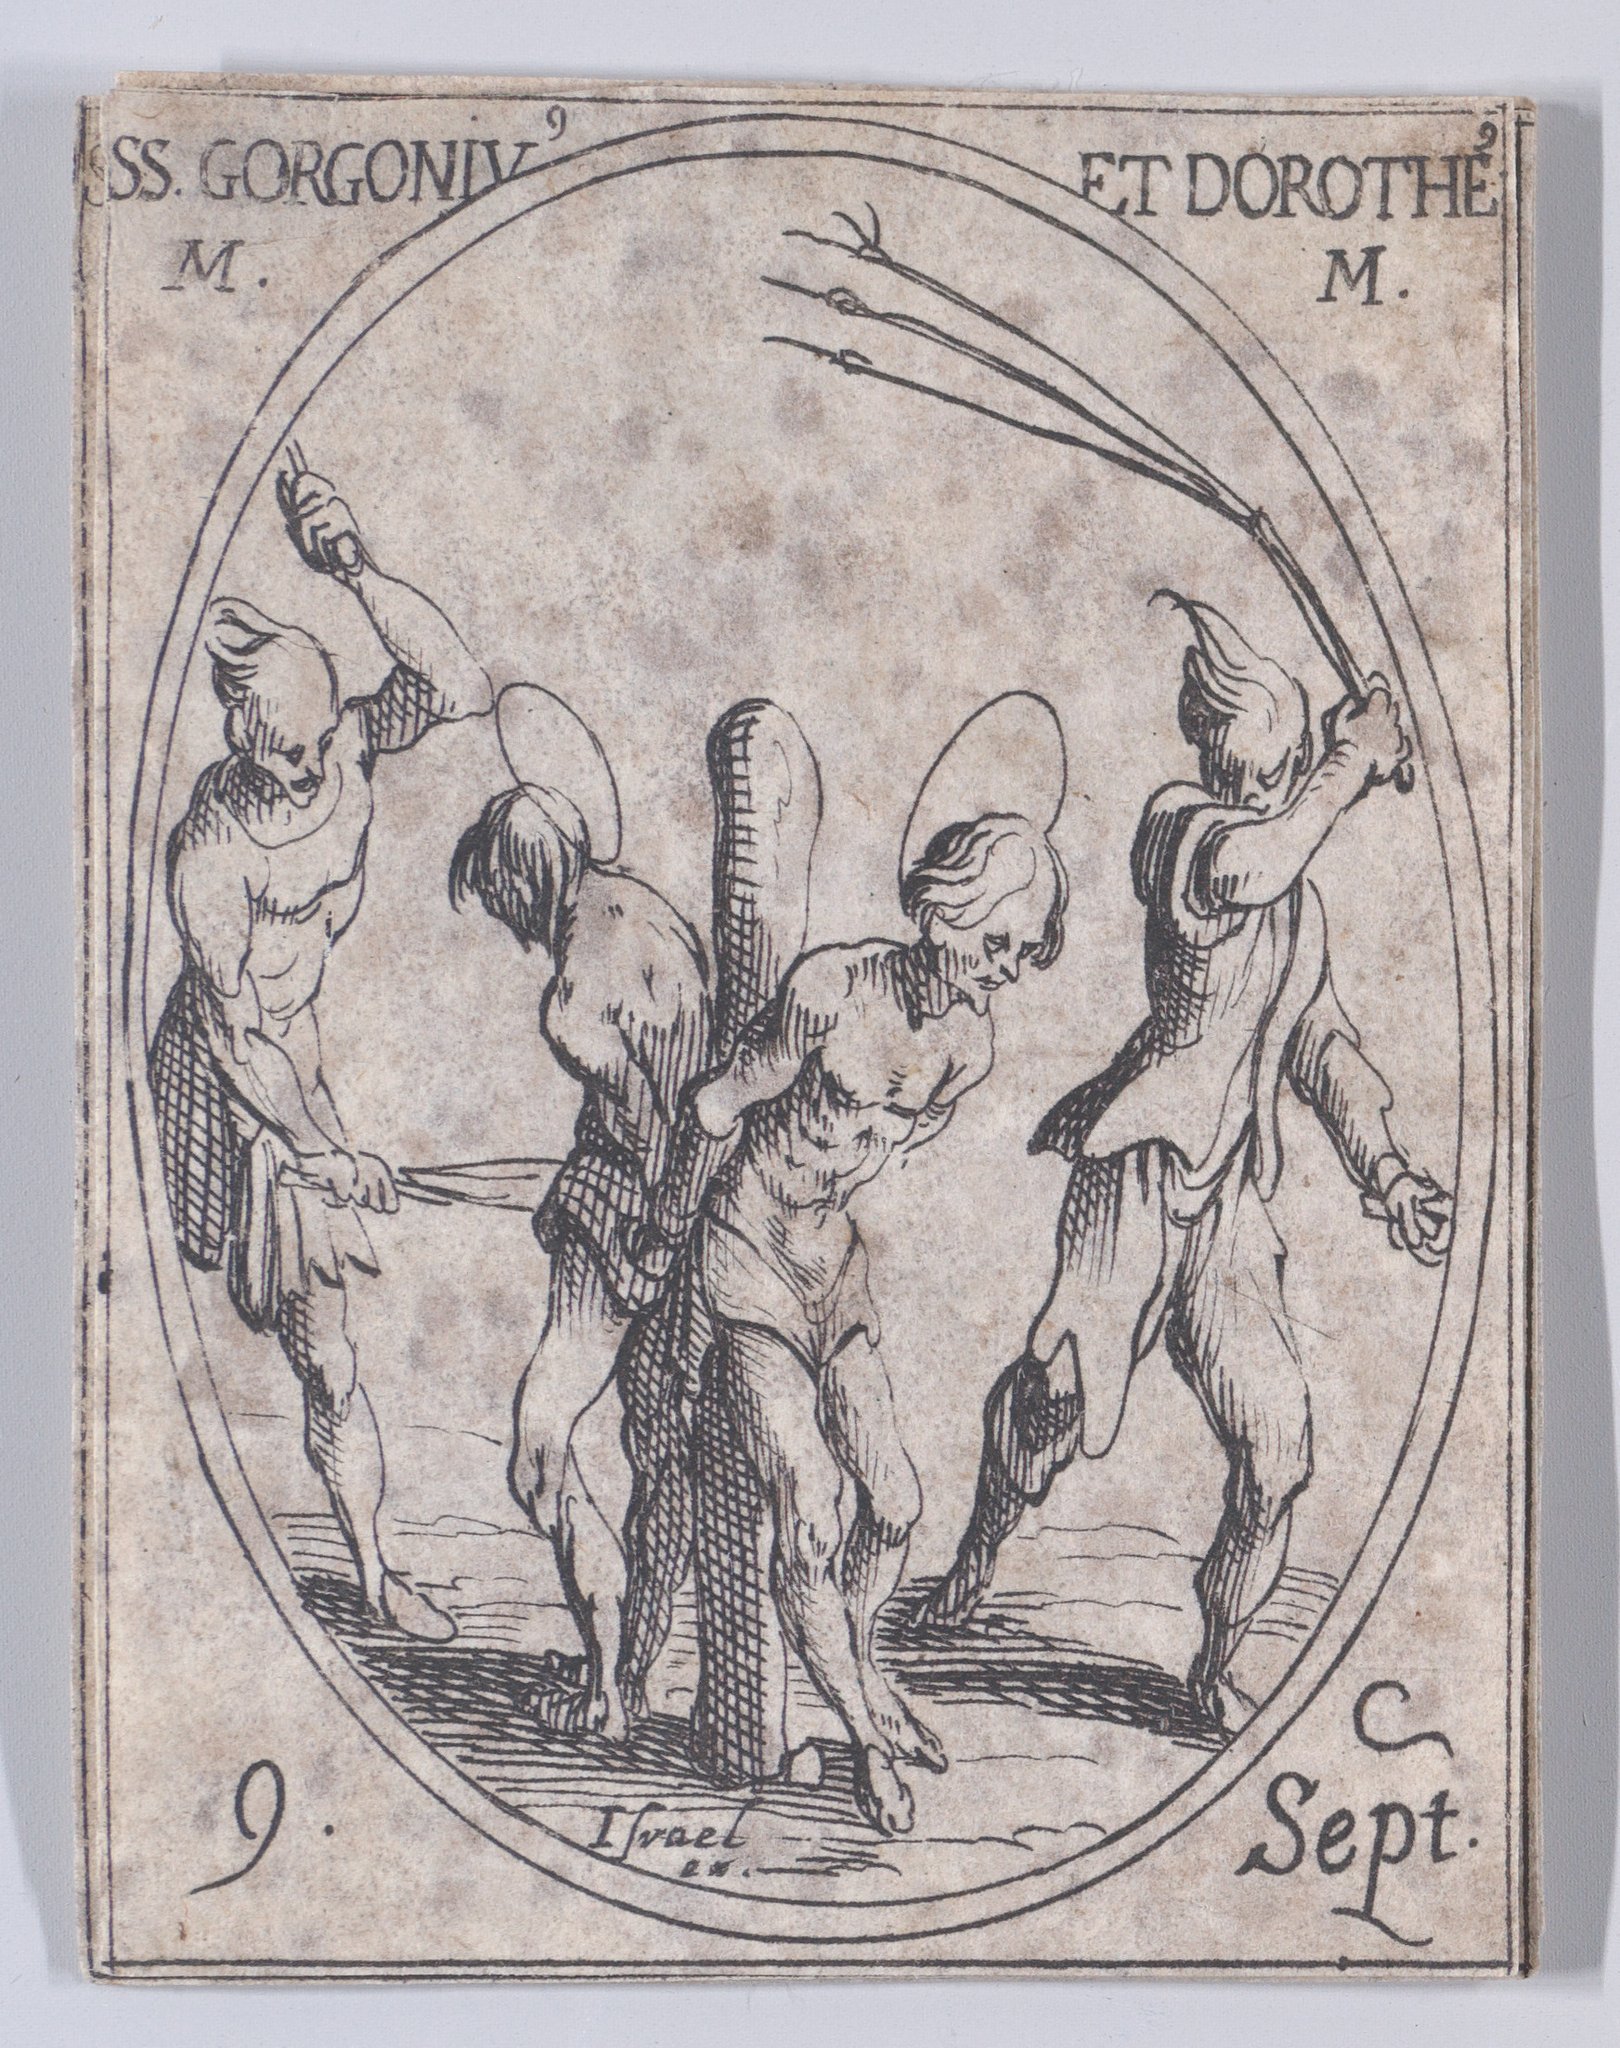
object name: print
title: S. Gorgon et St. Dorothée, martyrs (St. Gorgonius and St. Dorotheus, Martyrs), September 9th, from "Les Images De Tous Les Saincts et Saintes de L'Année" (Images of All of the Saints and Religious Events of the Year)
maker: jacques callot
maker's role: artist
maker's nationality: french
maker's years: 1592-1635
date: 1636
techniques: etching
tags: men,saints